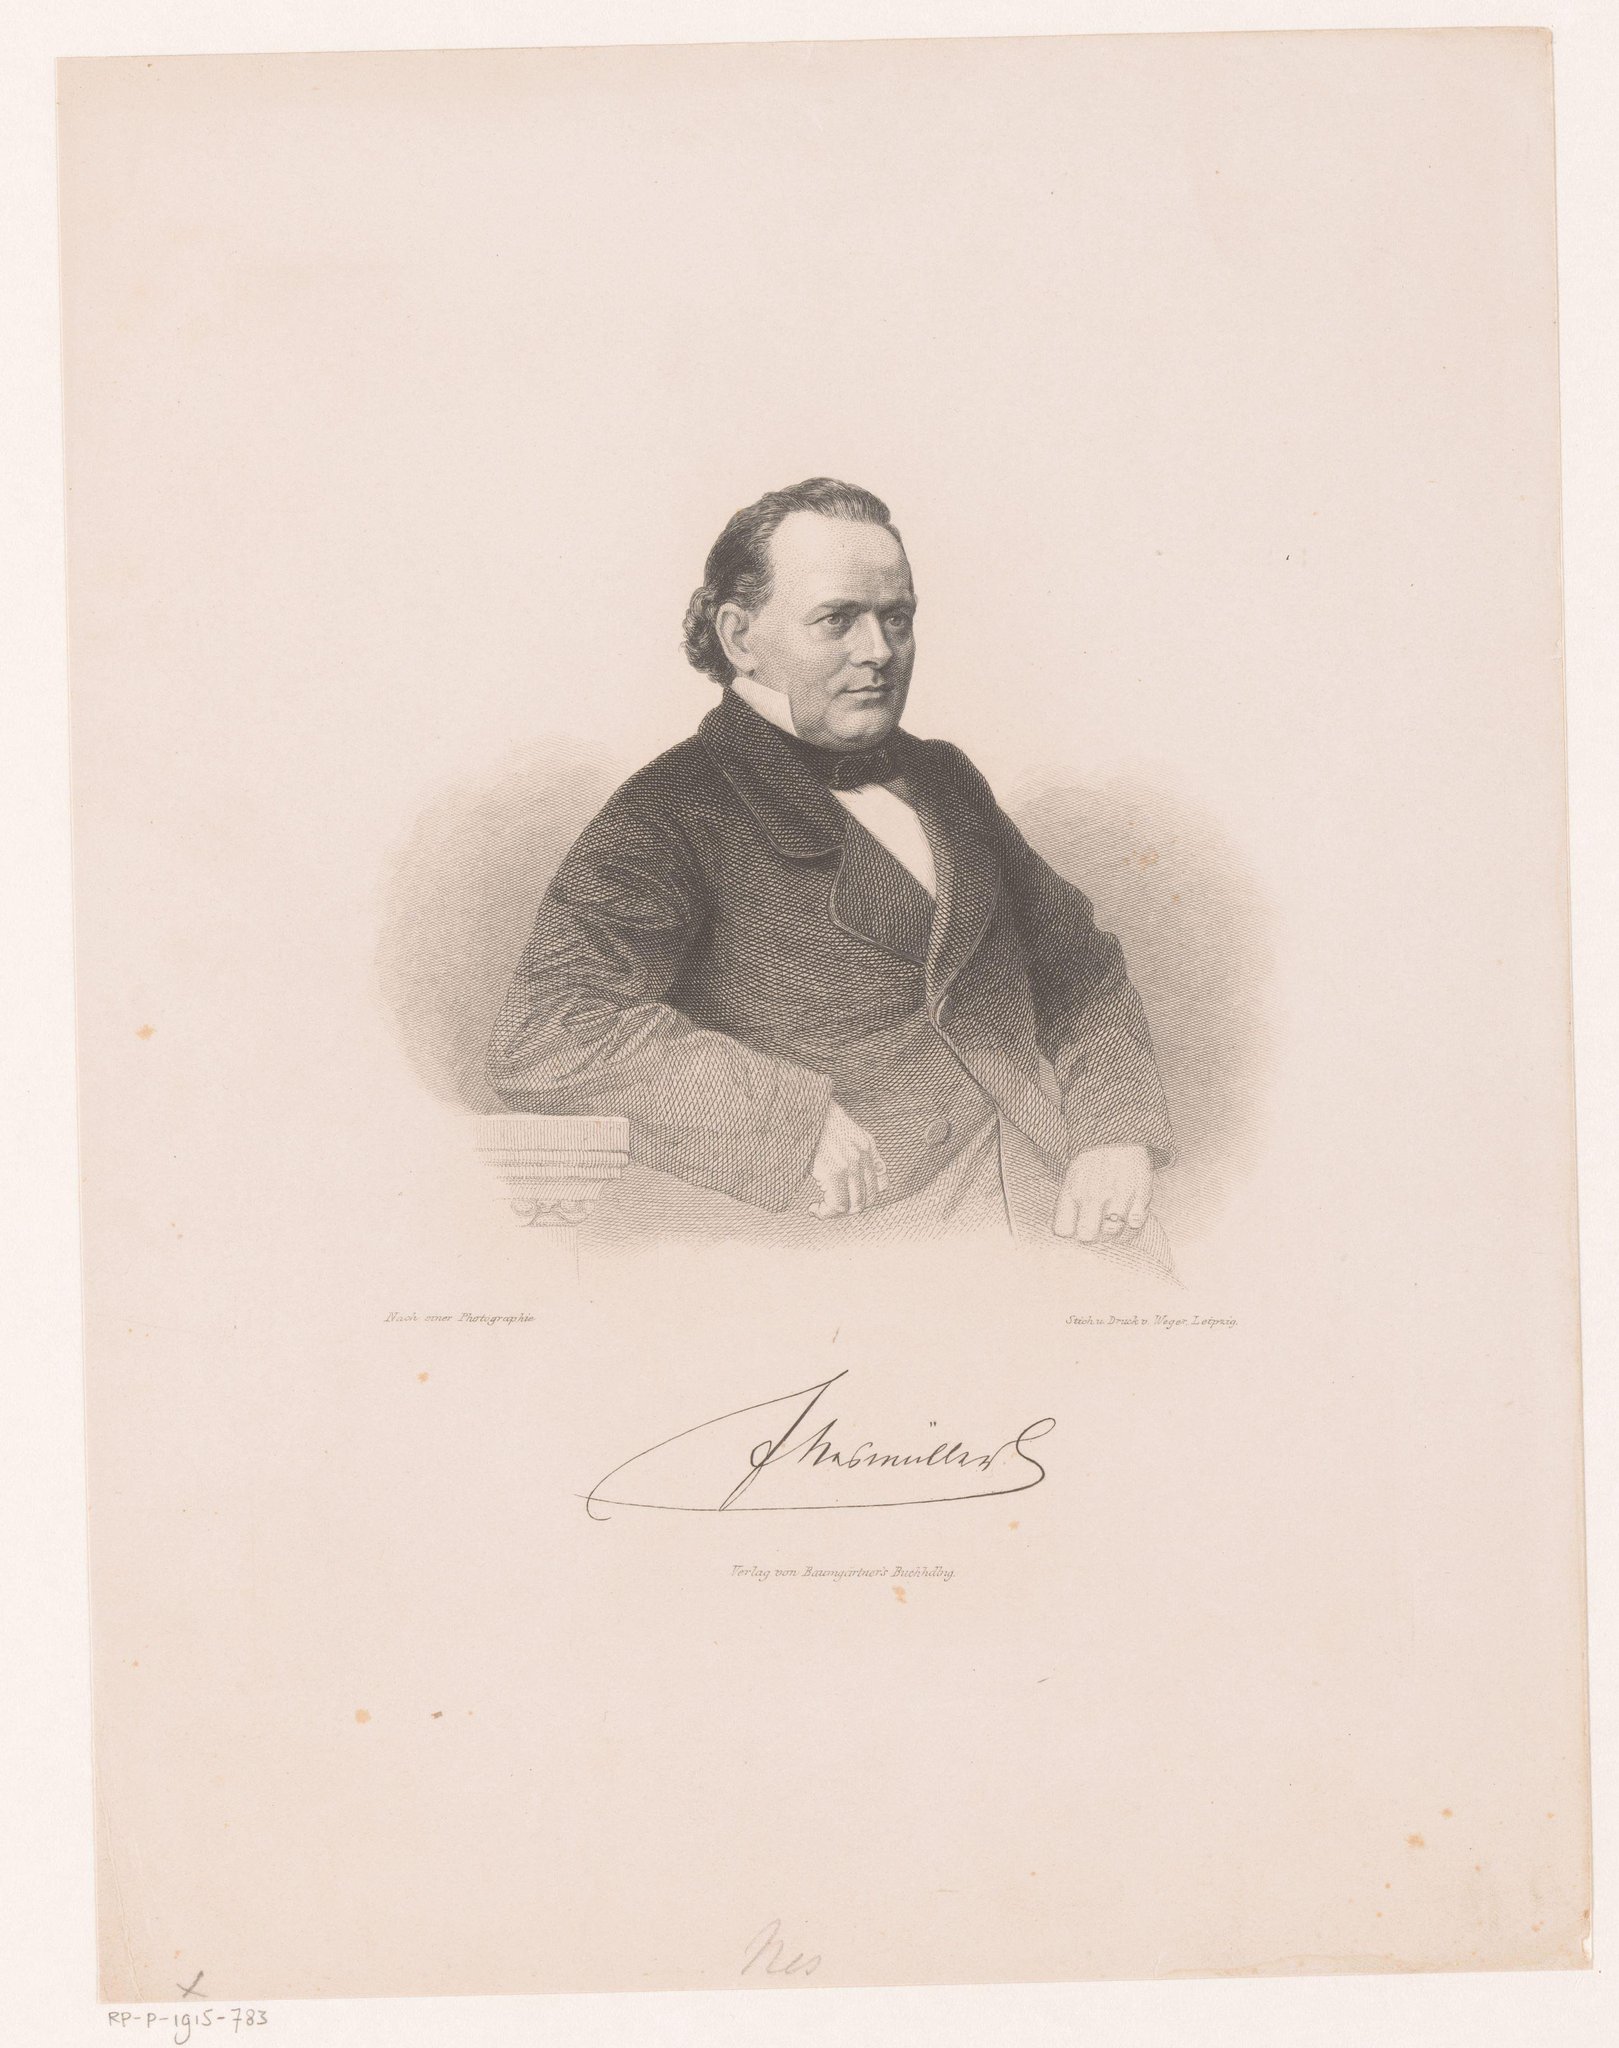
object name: print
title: Portret van Ferdinand Nesmüller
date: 1860-1892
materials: paper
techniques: engraving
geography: leipzig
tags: historical persons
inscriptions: collector's mark: Lugt 2228